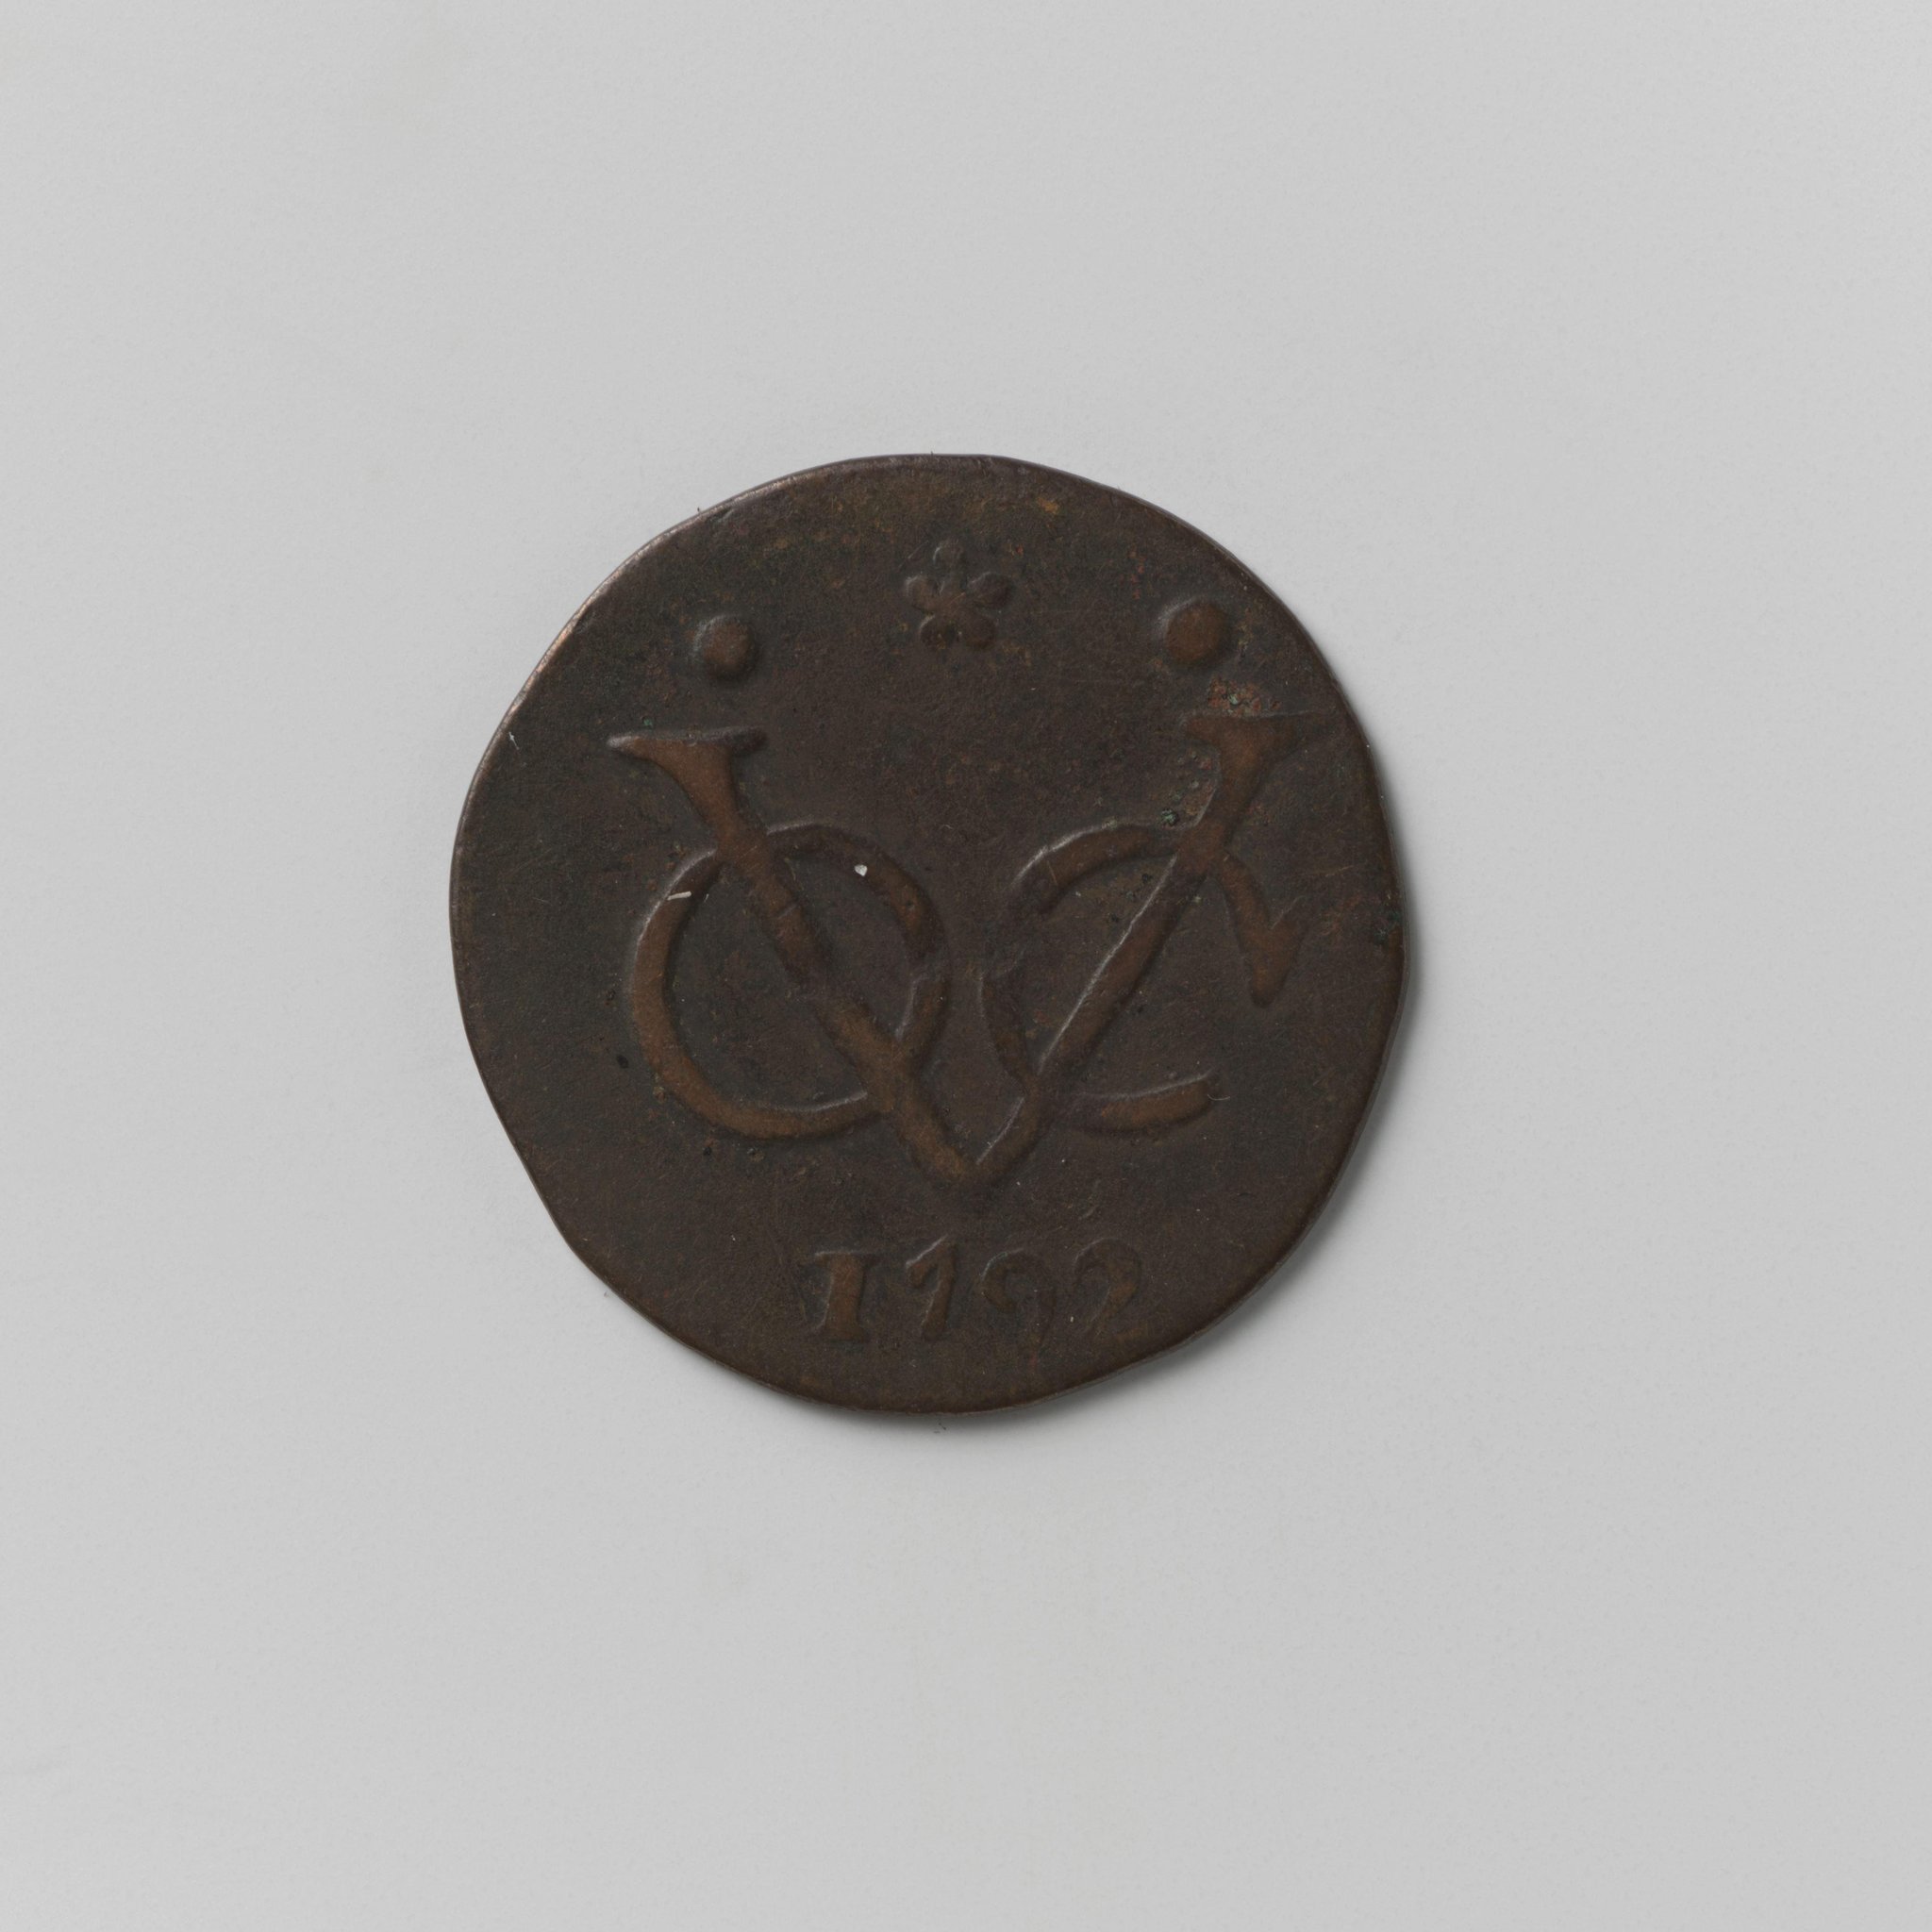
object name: coin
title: Nabootsing van een duit van de VOC uit West-Friesland, 1792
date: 1792-1830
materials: copper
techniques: striking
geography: banjarmasin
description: Koperen munt. Nabootsing van duit van de VOC uit West-Friesland. Voorzijde: gekroond wapenschild van West-Friesland. Keerzijde: monogram van de VOC, waarboven rozet en waaronder fictief jaartal.